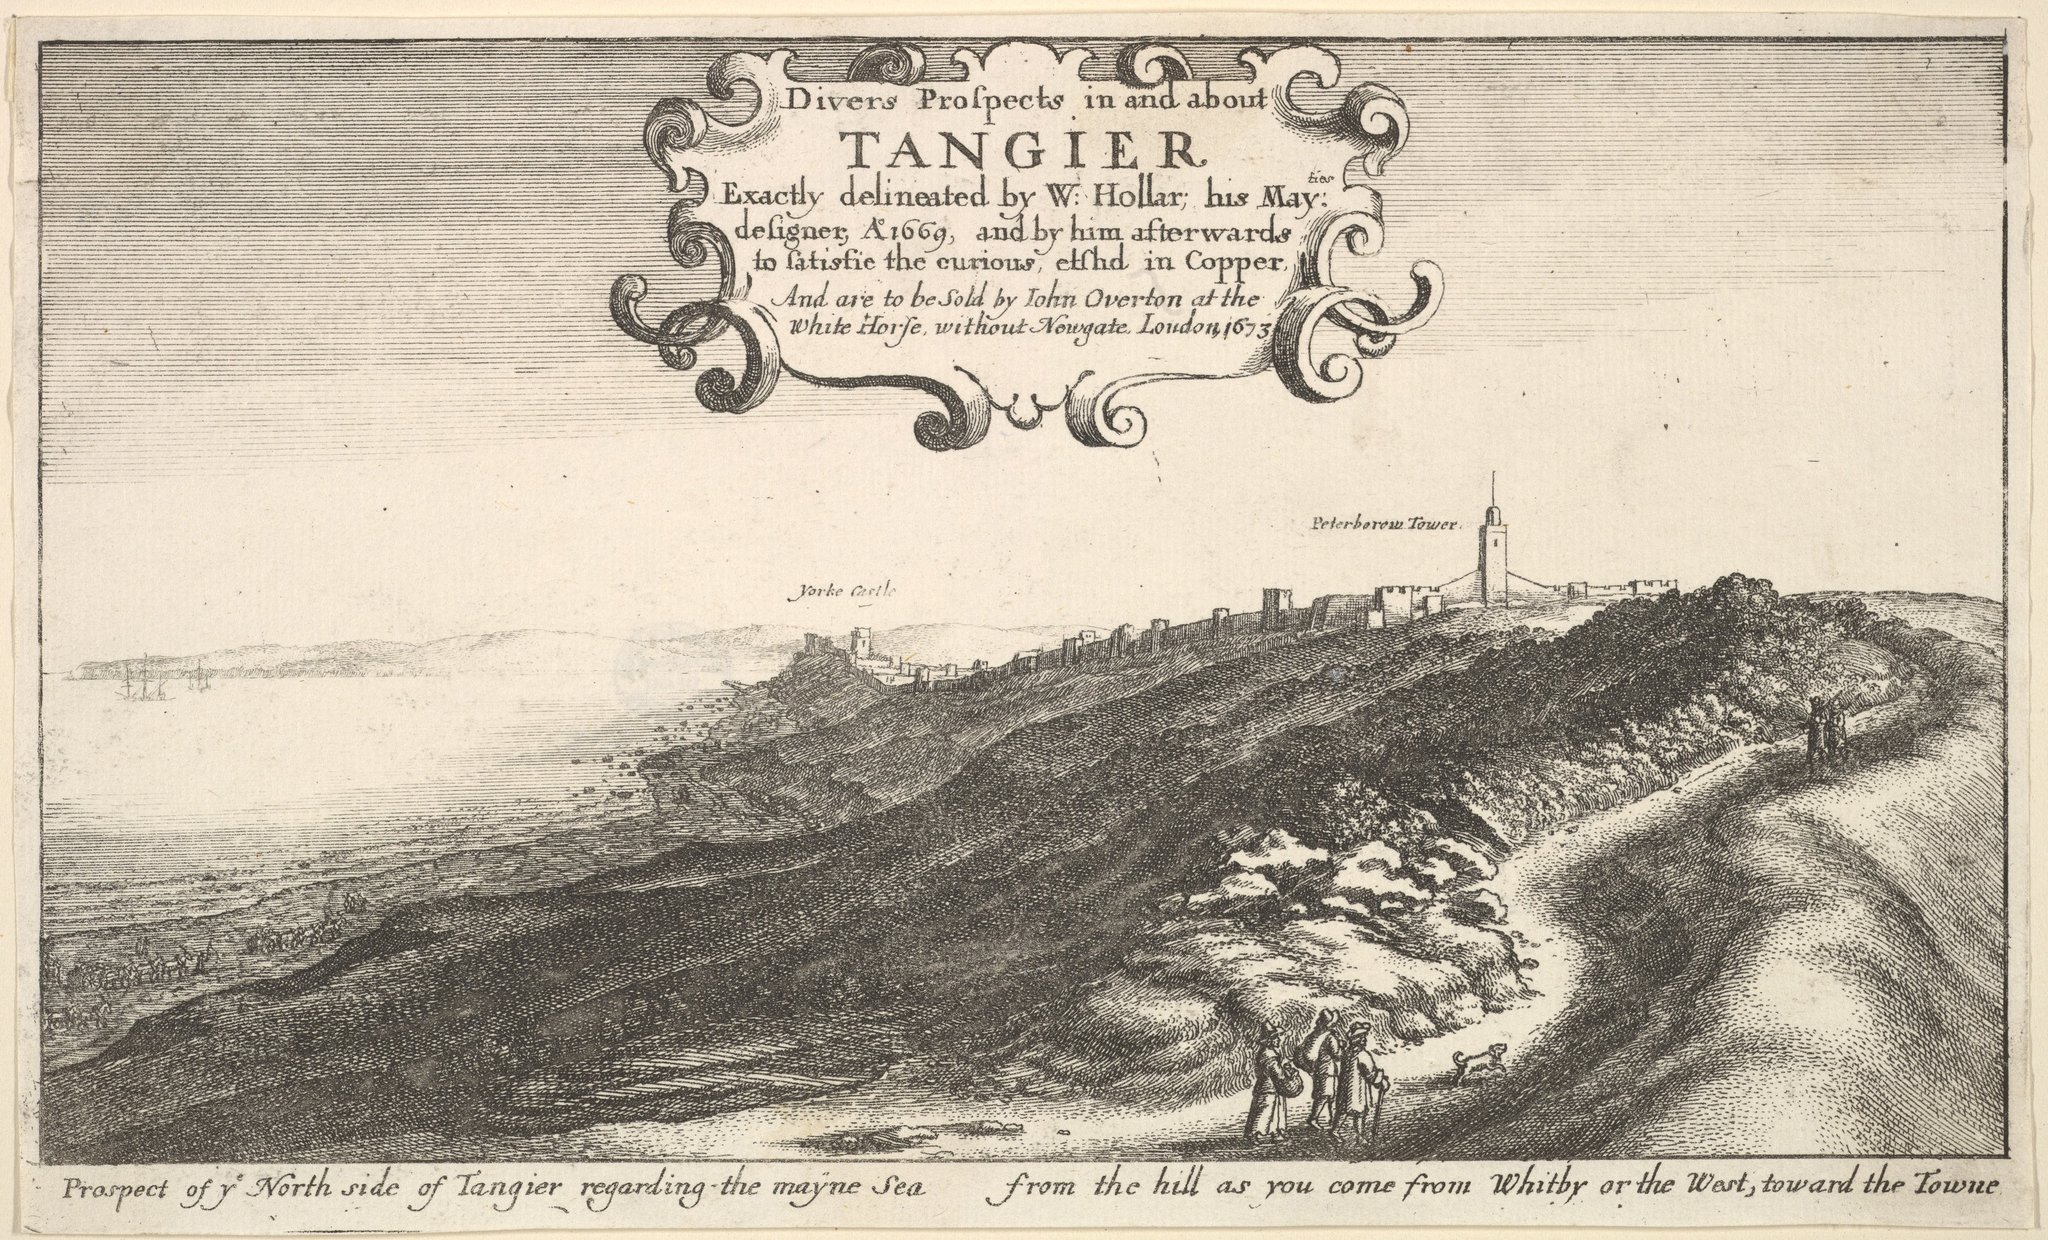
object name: print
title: Prospect of ye North side of Tangier regarding the mayne Sea from the hill as you come from Whitby or the West, toward the Towne, from "Views of Tangier"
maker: wenceslaus hollar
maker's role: artist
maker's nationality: bohemian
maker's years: 1607-1677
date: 1673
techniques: etching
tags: landscapes